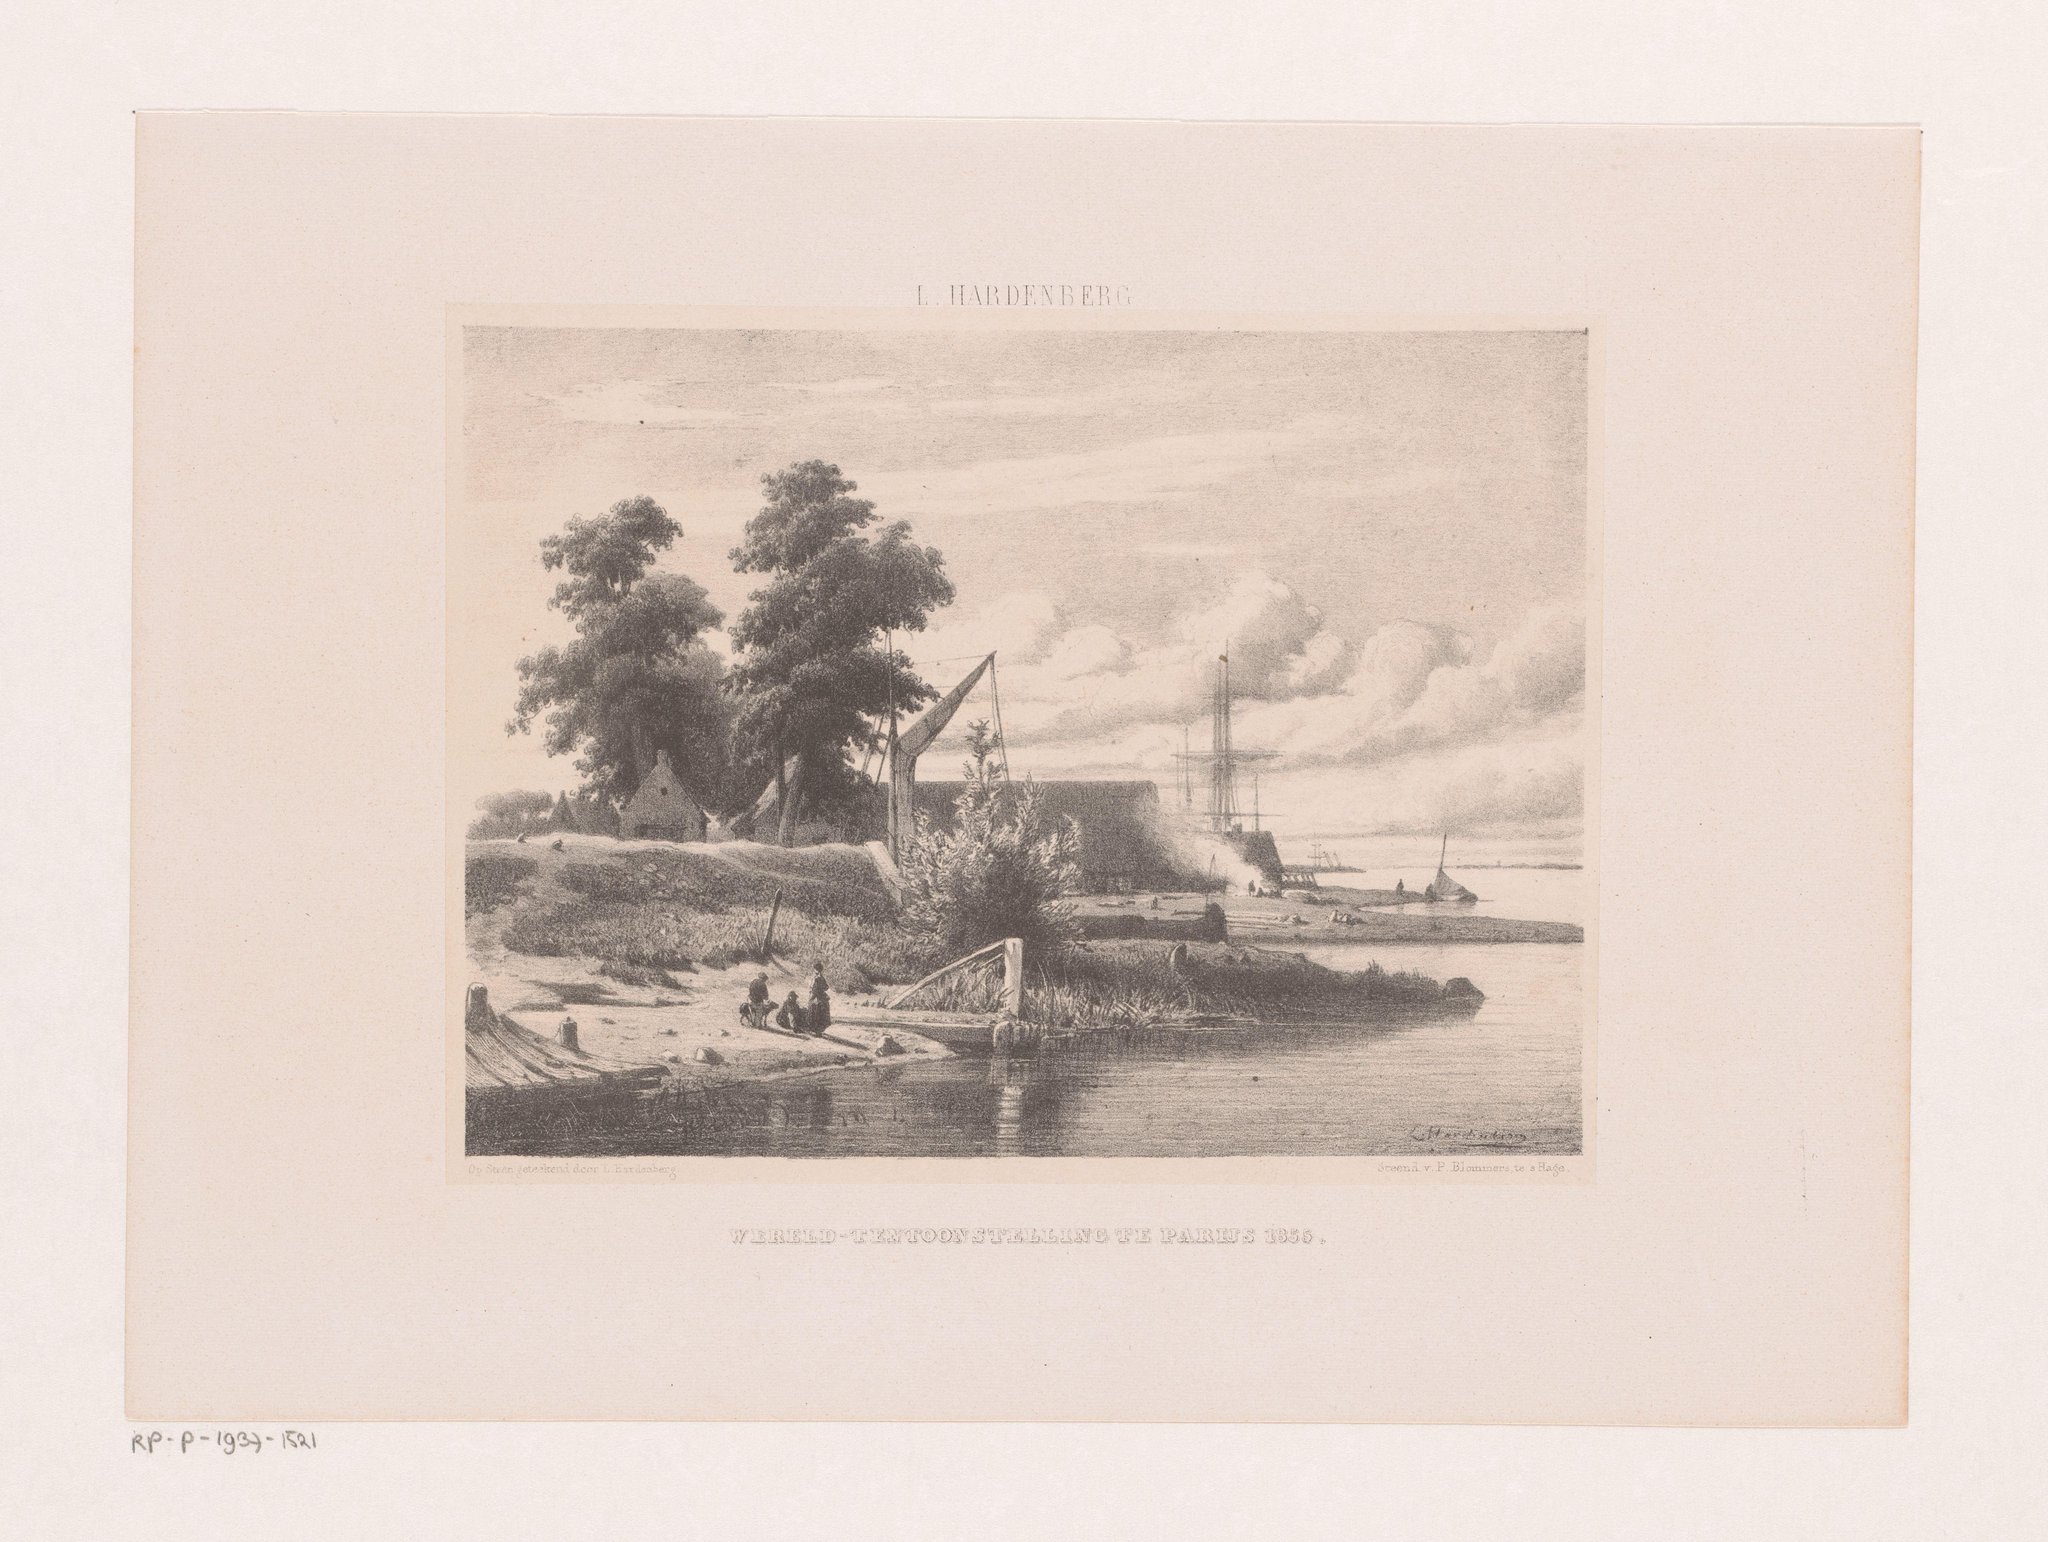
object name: print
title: Riviergezicht aan de Maas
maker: lambertus hardenberg (1822-1900)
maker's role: draughtsman, painter, print maker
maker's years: 1822-1900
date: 1855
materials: paper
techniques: lithograph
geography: the hague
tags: sailing-ship, sailing-boat, river bank, pier, quay, wharf, river (+ landscape with figures, staffage)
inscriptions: collector's mark: Lugt 2228, collector's mark: Lugt 2760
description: Op de oever liggen aanlegsteigers, verderop staan huizen. Achter bomen en huizen steken masten en zeilen van zeilschepen uit.